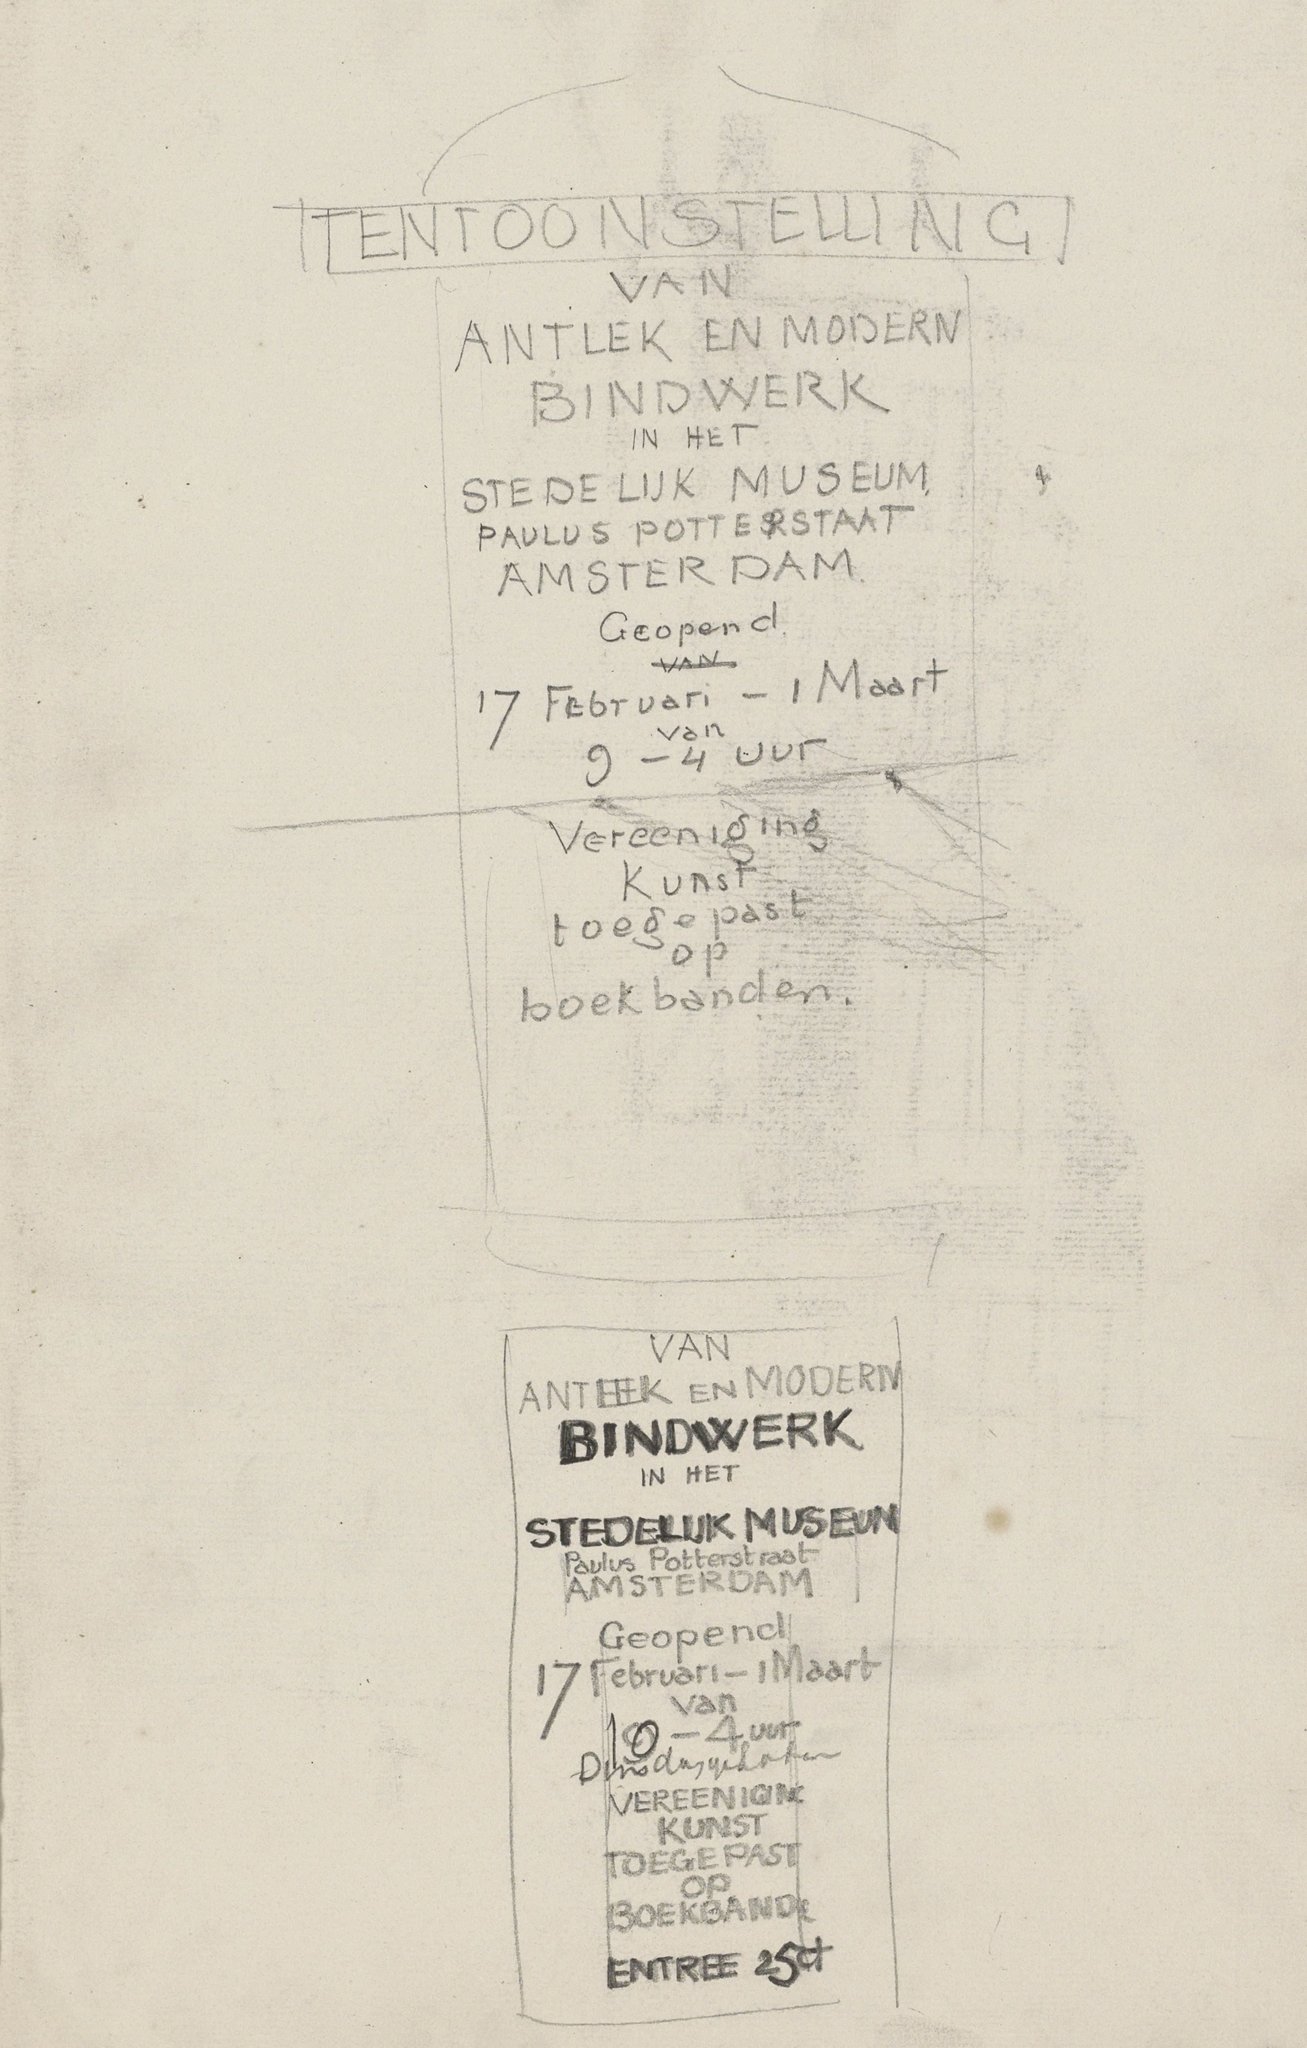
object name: sketchbook leaf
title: Ontwerp voor een tentoonstellingsaffiche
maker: carel adolph lion cachet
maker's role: draughtsman, print maker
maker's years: 1864-1945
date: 1895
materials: paper, pencil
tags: printed matter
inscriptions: annotation: ‘TENTOONSTELLING/ VAN ANTIEK EN MODERN/ BINDWERK/ IN HET/ STEDELIJK MUSEUM/ PAULUS POTTERSTRAAT/ AMSTERDAM/ Geopend/ 17 Februari - 1 Maart/ van 9-4 uur/ Vereeniging/ Kunst/ toegepast/ op/ boekbanden.’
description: Blad 19 recto uit een schetsboek met 23 bladen.